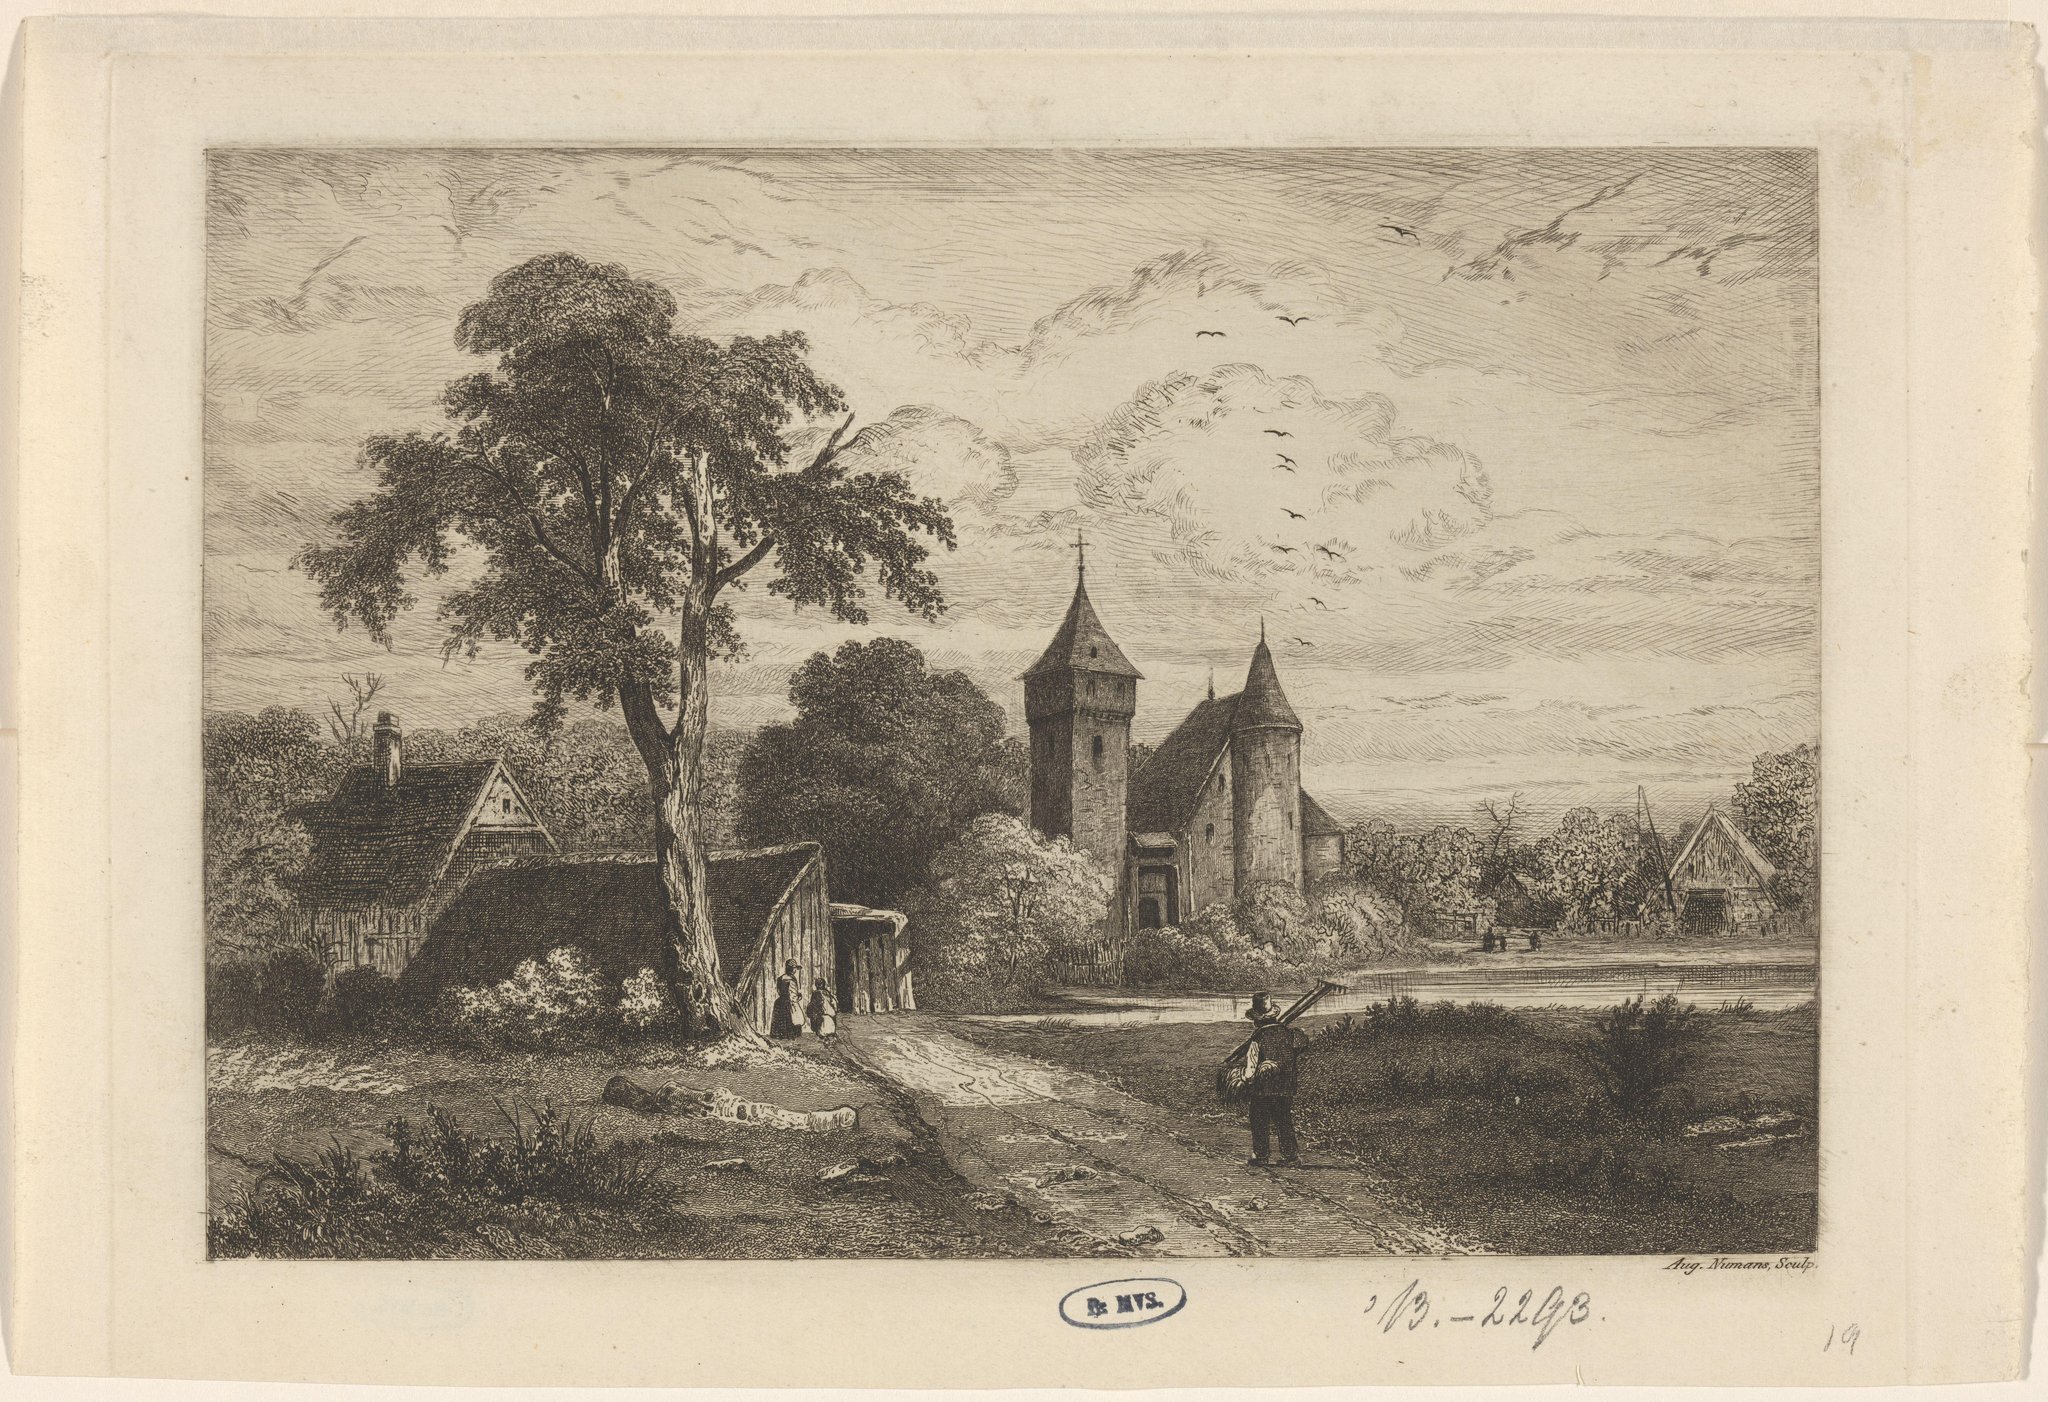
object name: print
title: Landschap met huizen en een kasteel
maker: auguste numans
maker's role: print maker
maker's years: 1823-1883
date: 1833-1879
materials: paper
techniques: etching, roulette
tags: road, path, landscape with tower or castle (+ city(-scape) with figures, staffage)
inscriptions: collector's mark: Lugt 2228